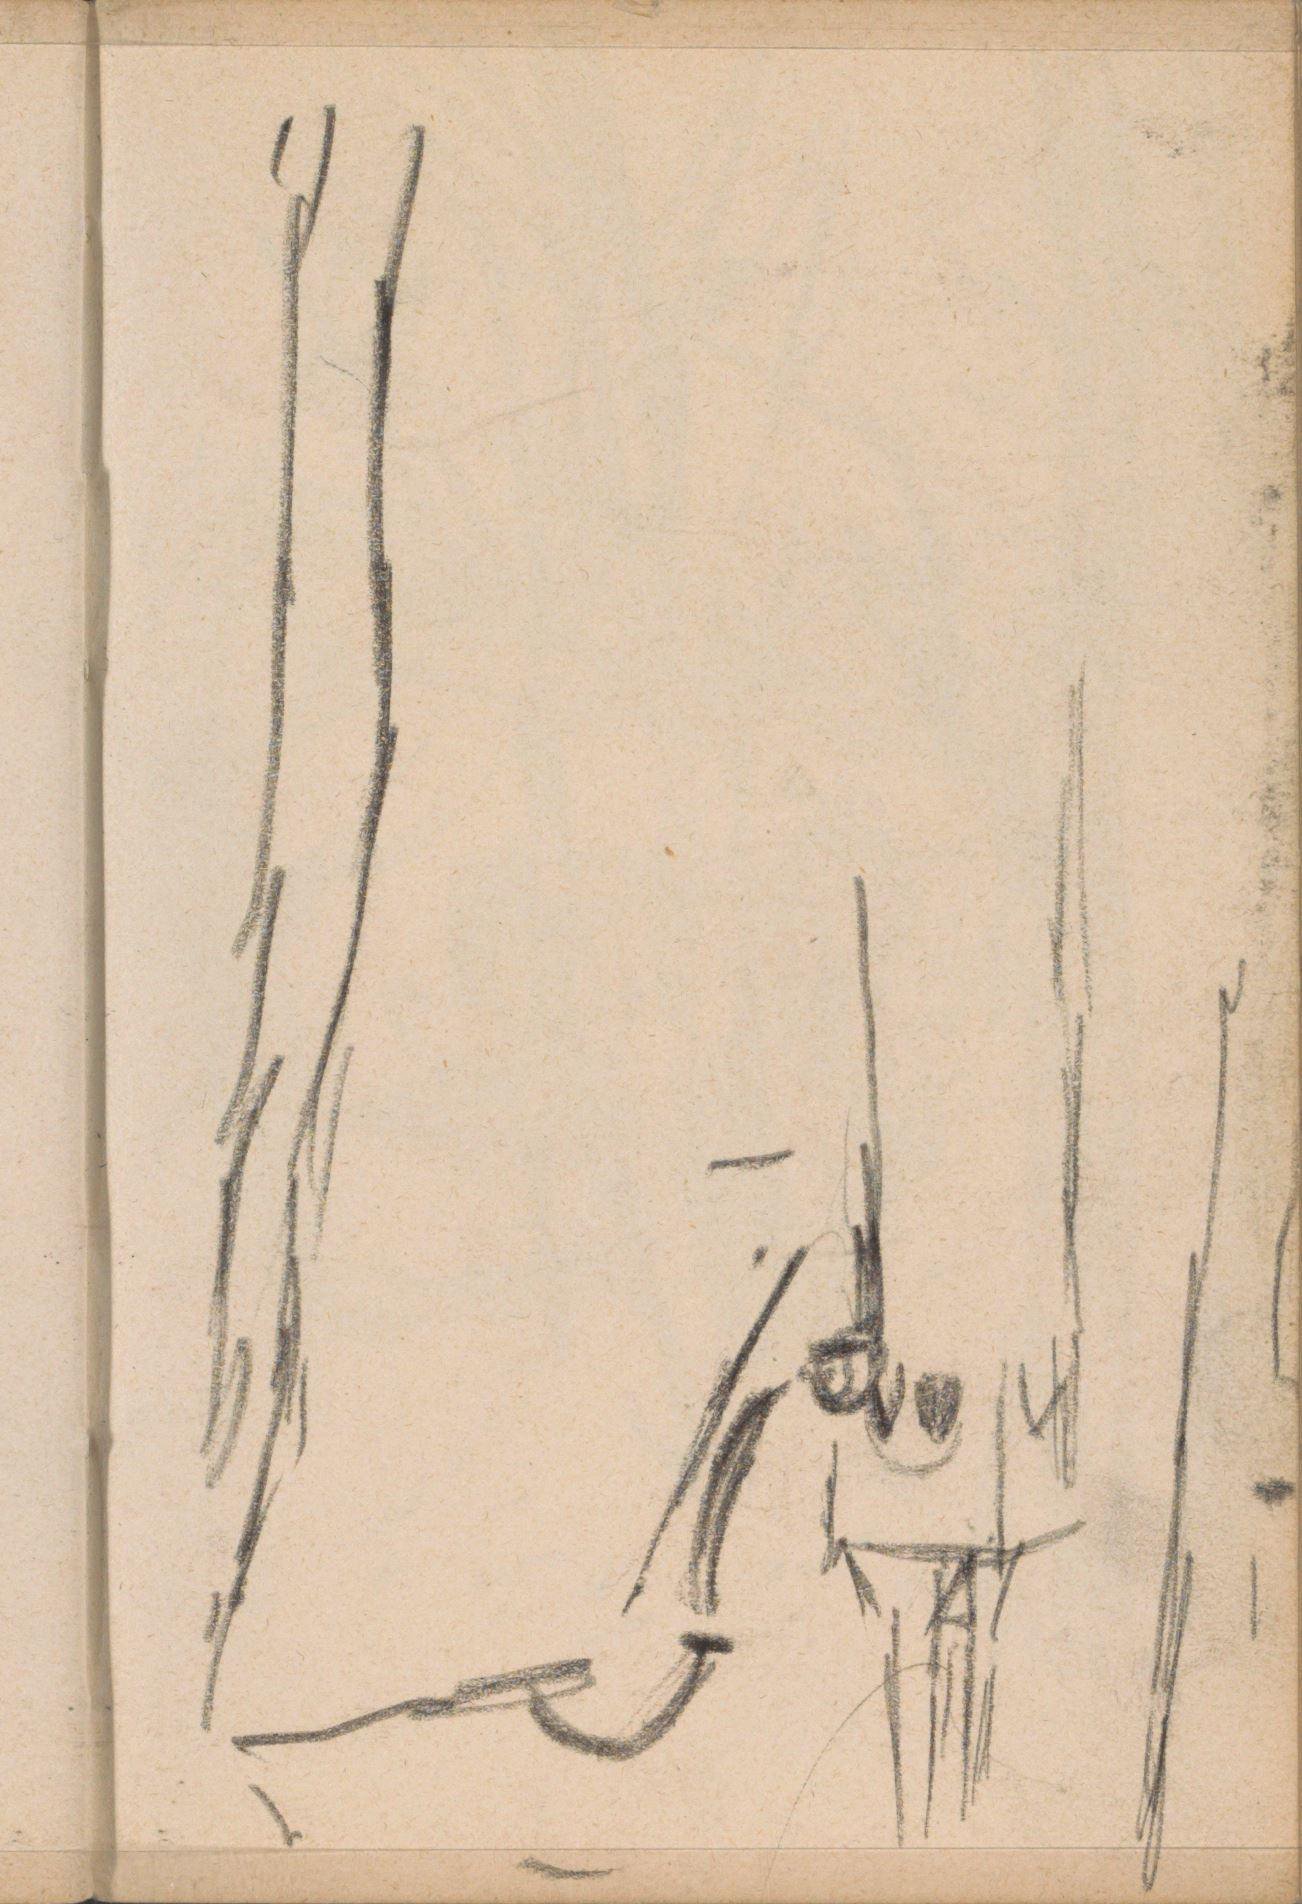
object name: sketchbook leaf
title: Gezicht in het Begijnhof te Amsterdam met de toren van de Engelse Hervormde Kerk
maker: george hendrik breitner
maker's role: draughtsman, painter, print maker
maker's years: 1857-1923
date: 1907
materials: chalk, paper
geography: amsterdam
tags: urban housing, parts of church exterior and annexes: tower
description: Gezicht in het Begijnhof te Amsterdam met de toren van de Engelse Hervormde Kerk. Pagina 46 uit een schetsboek met 46 bladen vervaardigd in Amsterdam, Rotterdam en Haarlem.